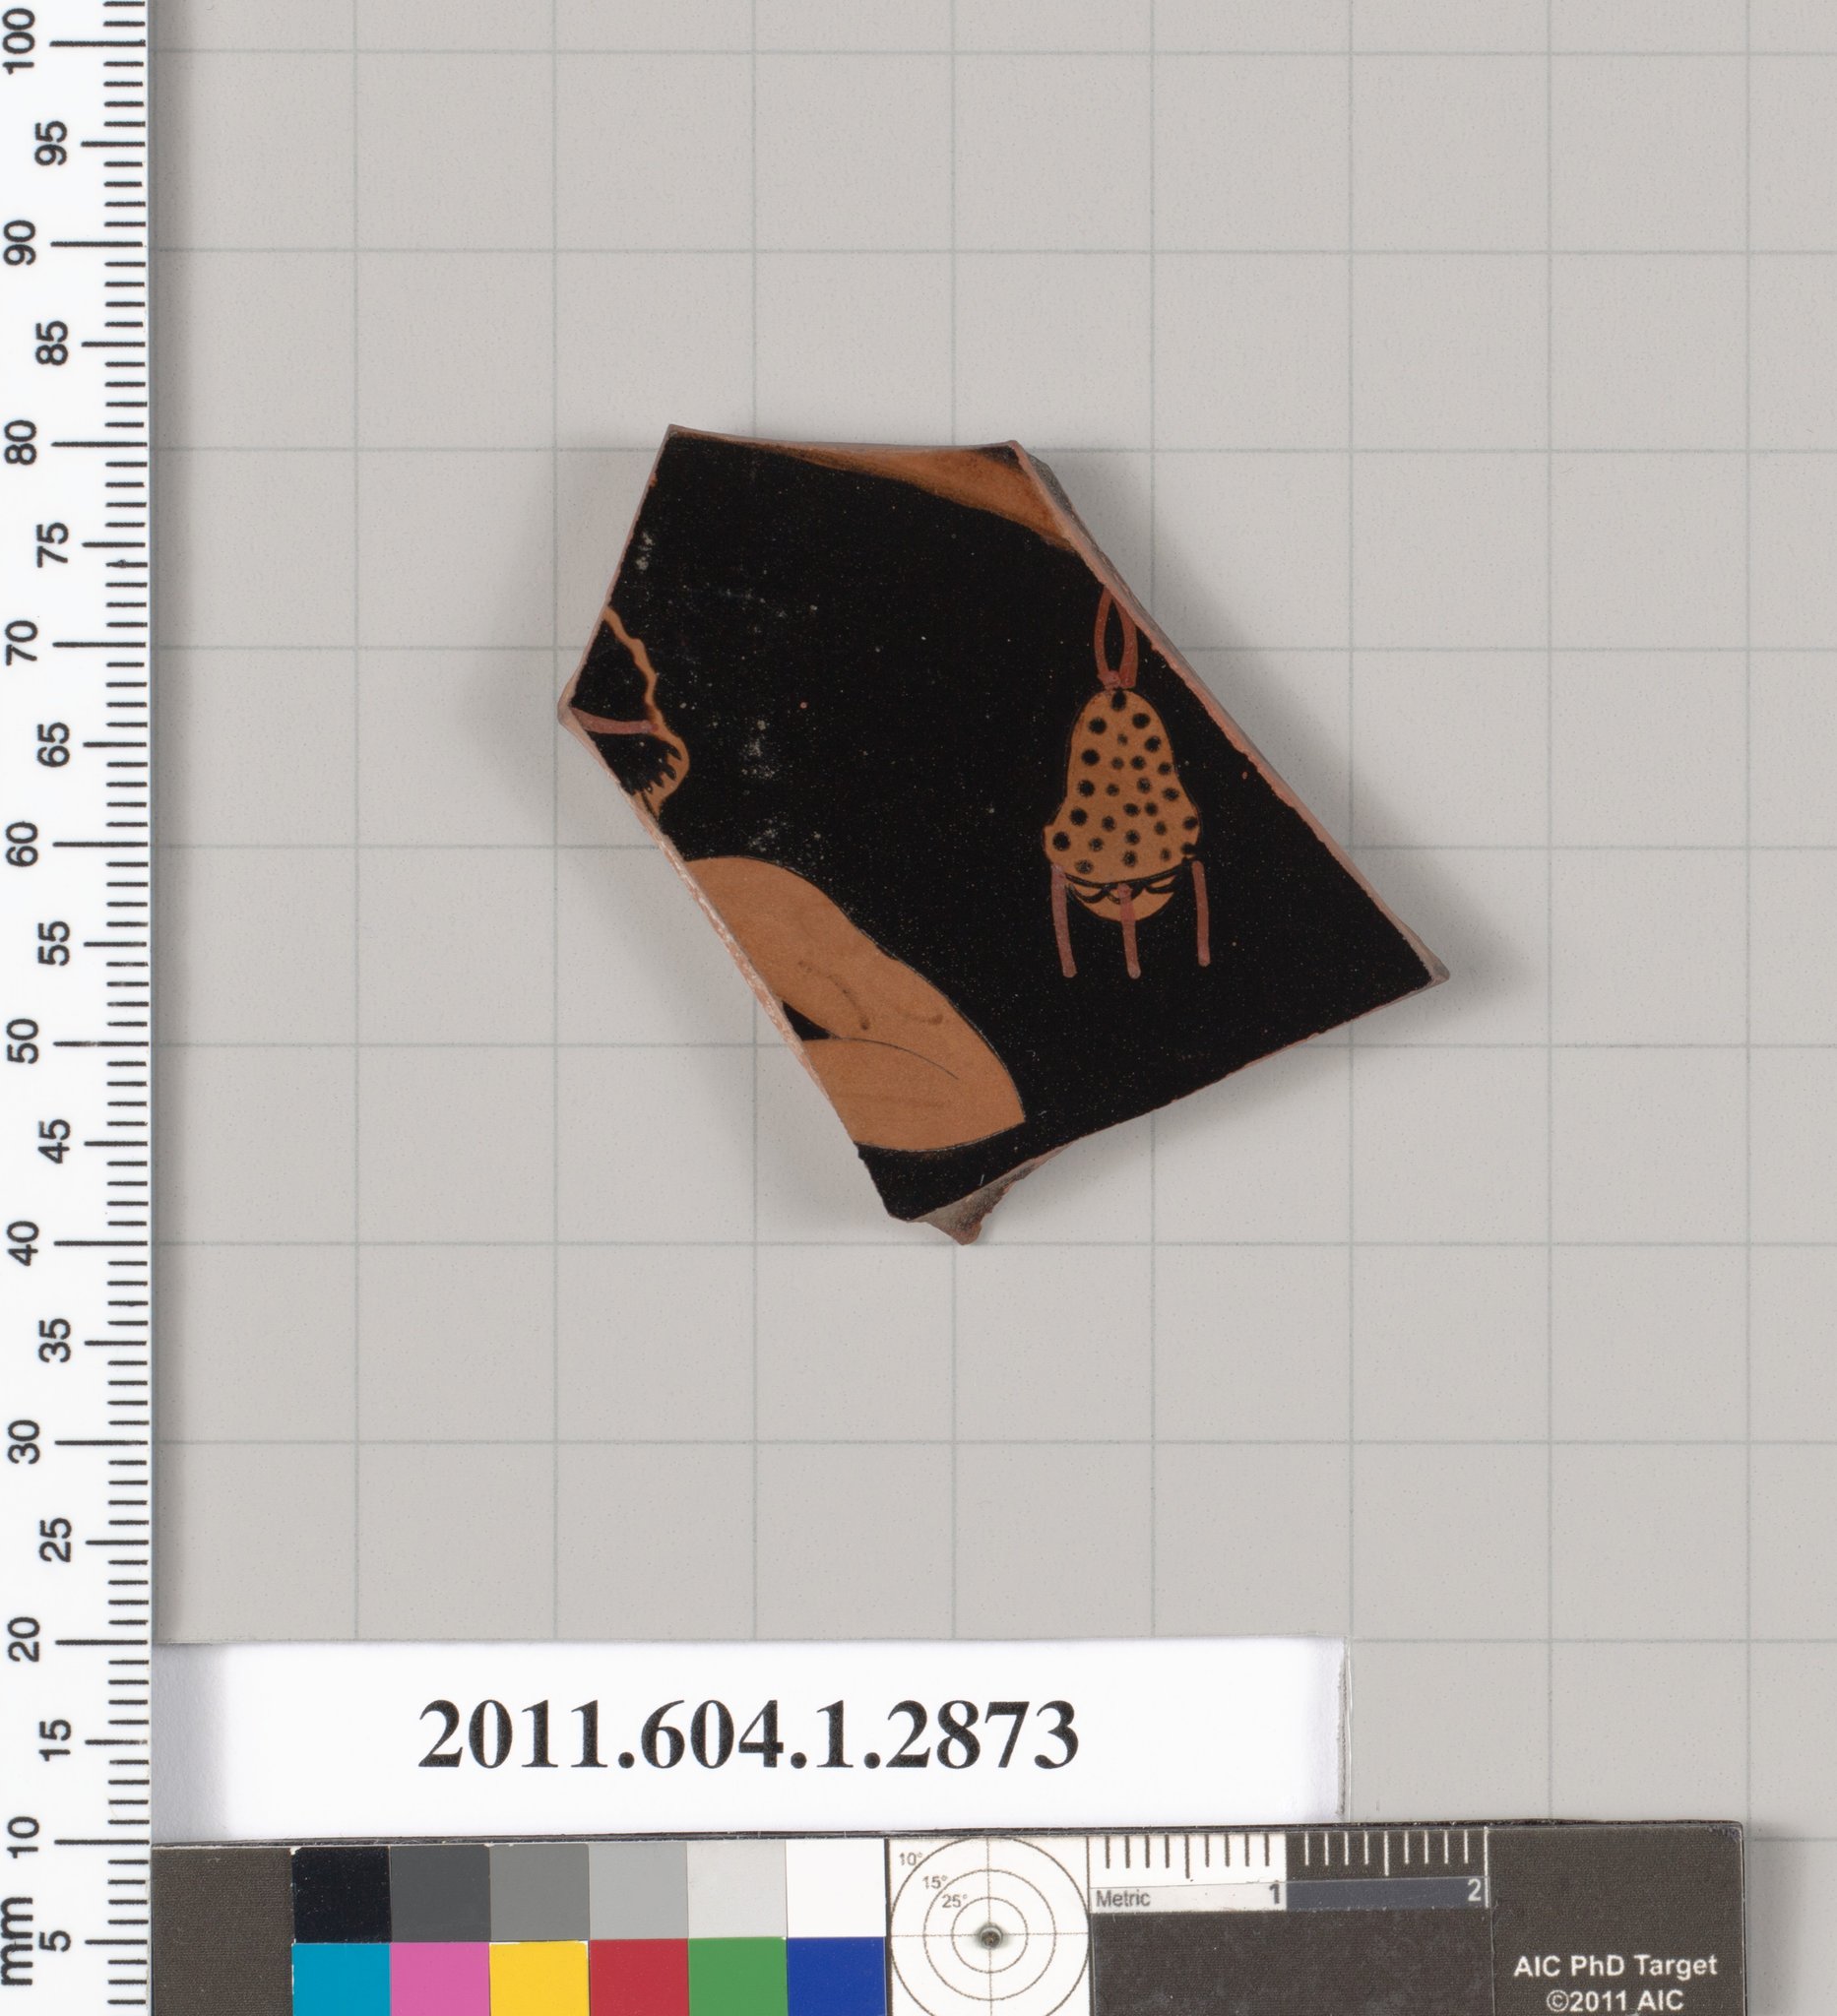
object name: kylix fragment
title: Terracotta fragment of a kylix (drinking cup)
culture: greek, attic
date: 510-490 BCE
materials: terracotta